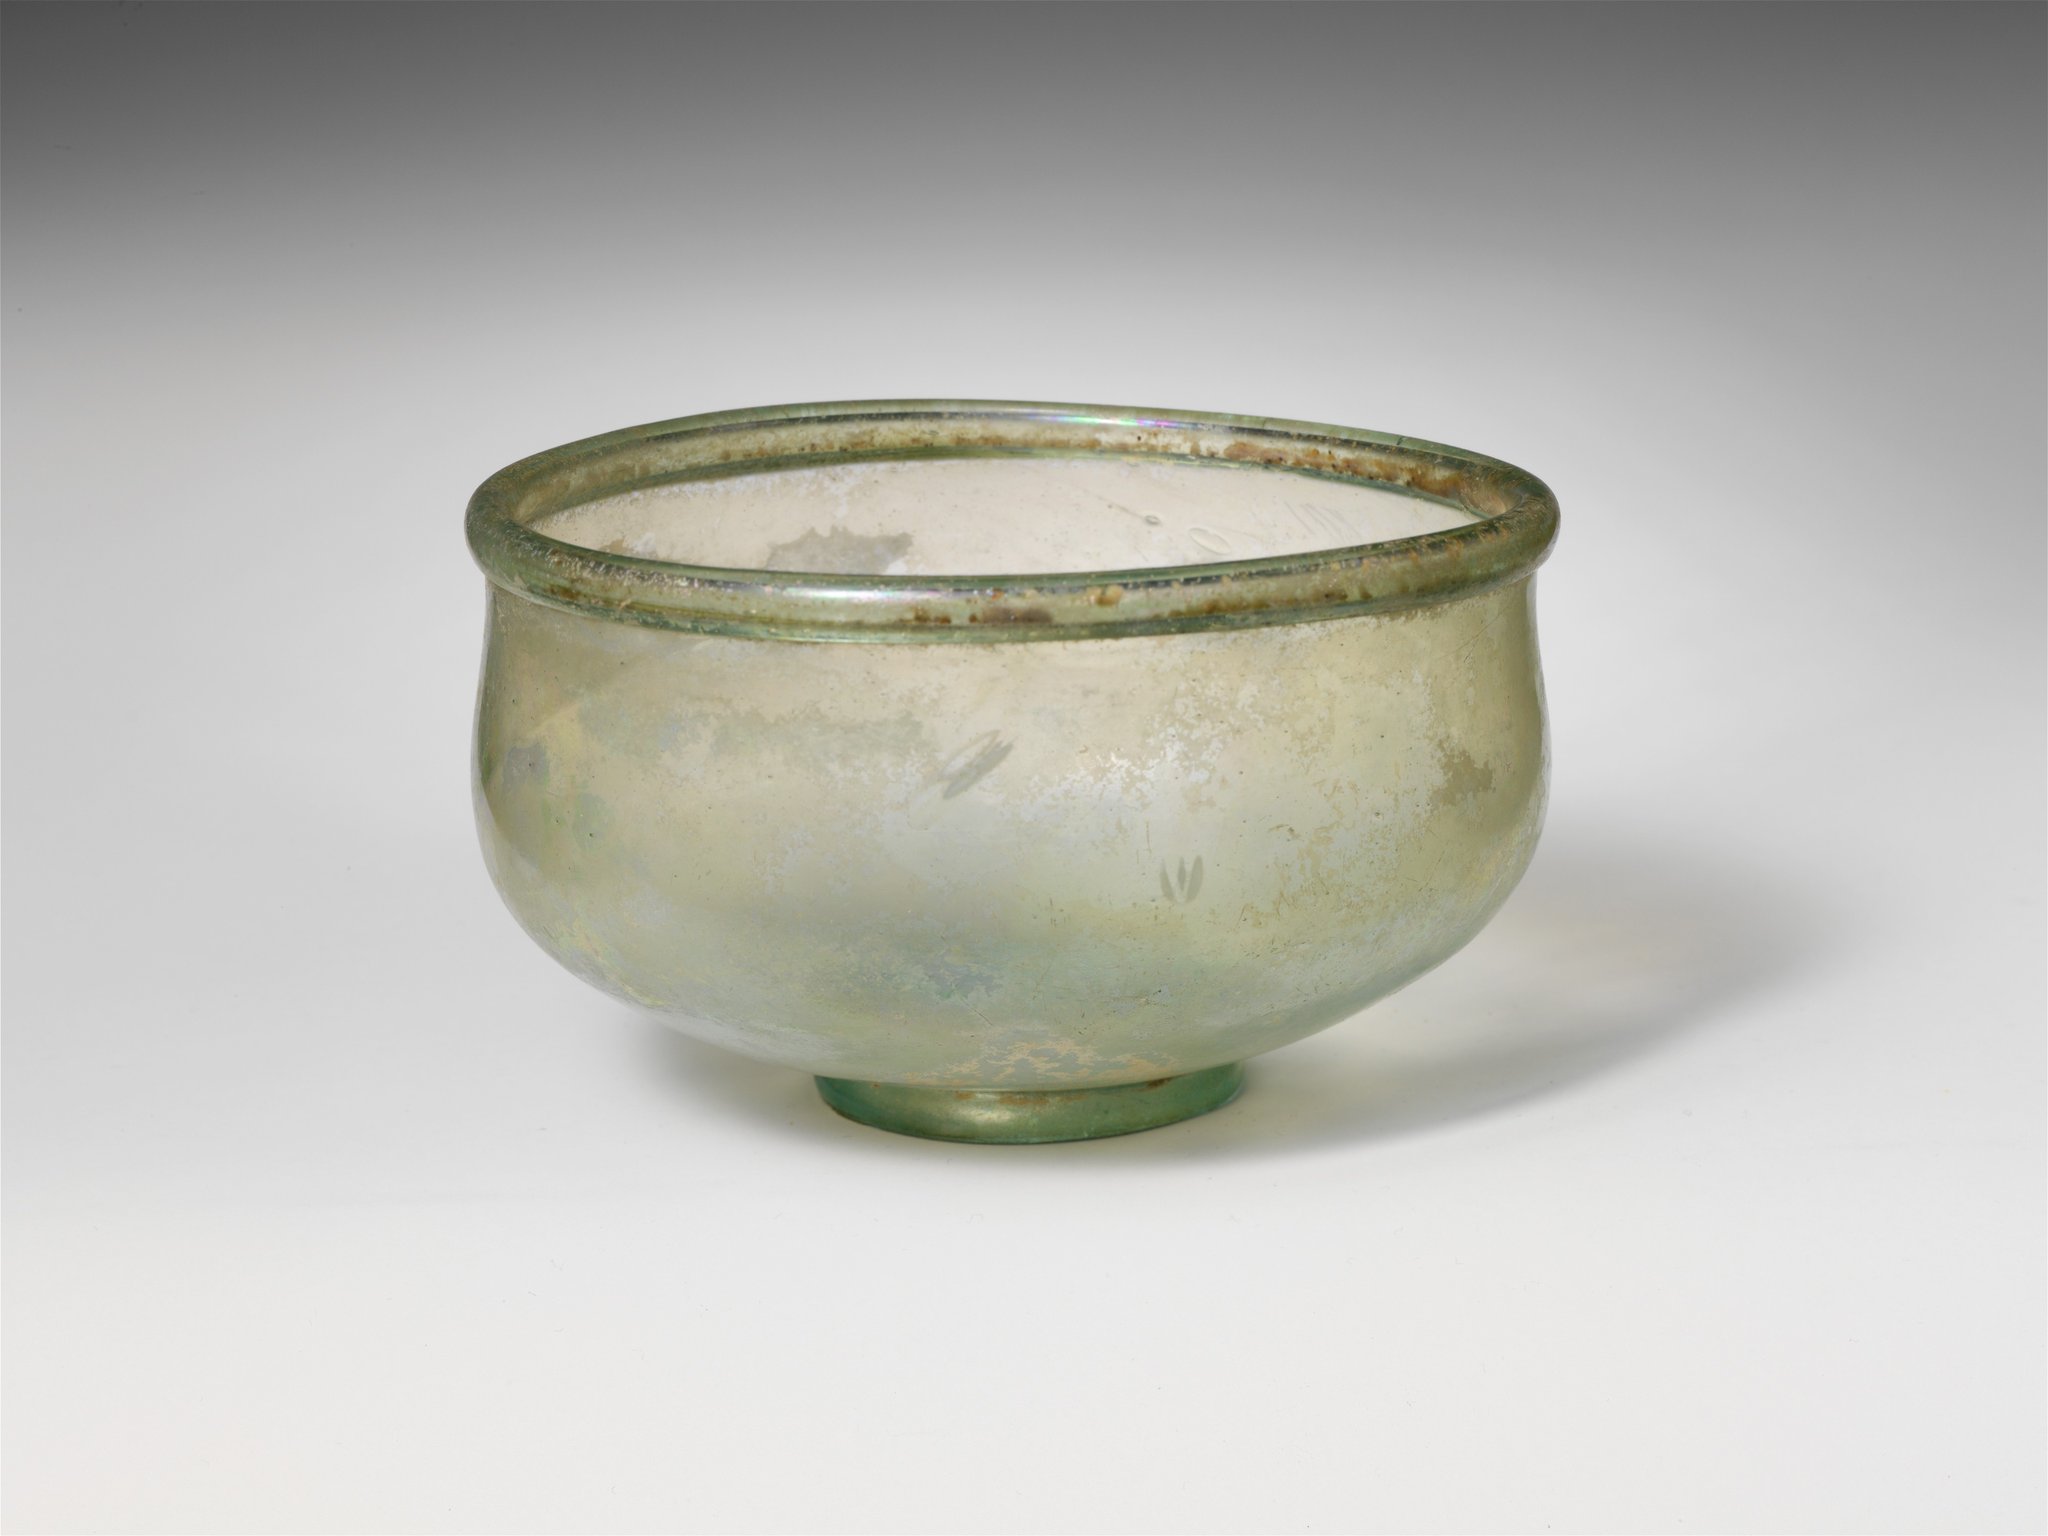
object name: bowl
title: Glass bowl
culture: roman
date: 51-100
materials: glass